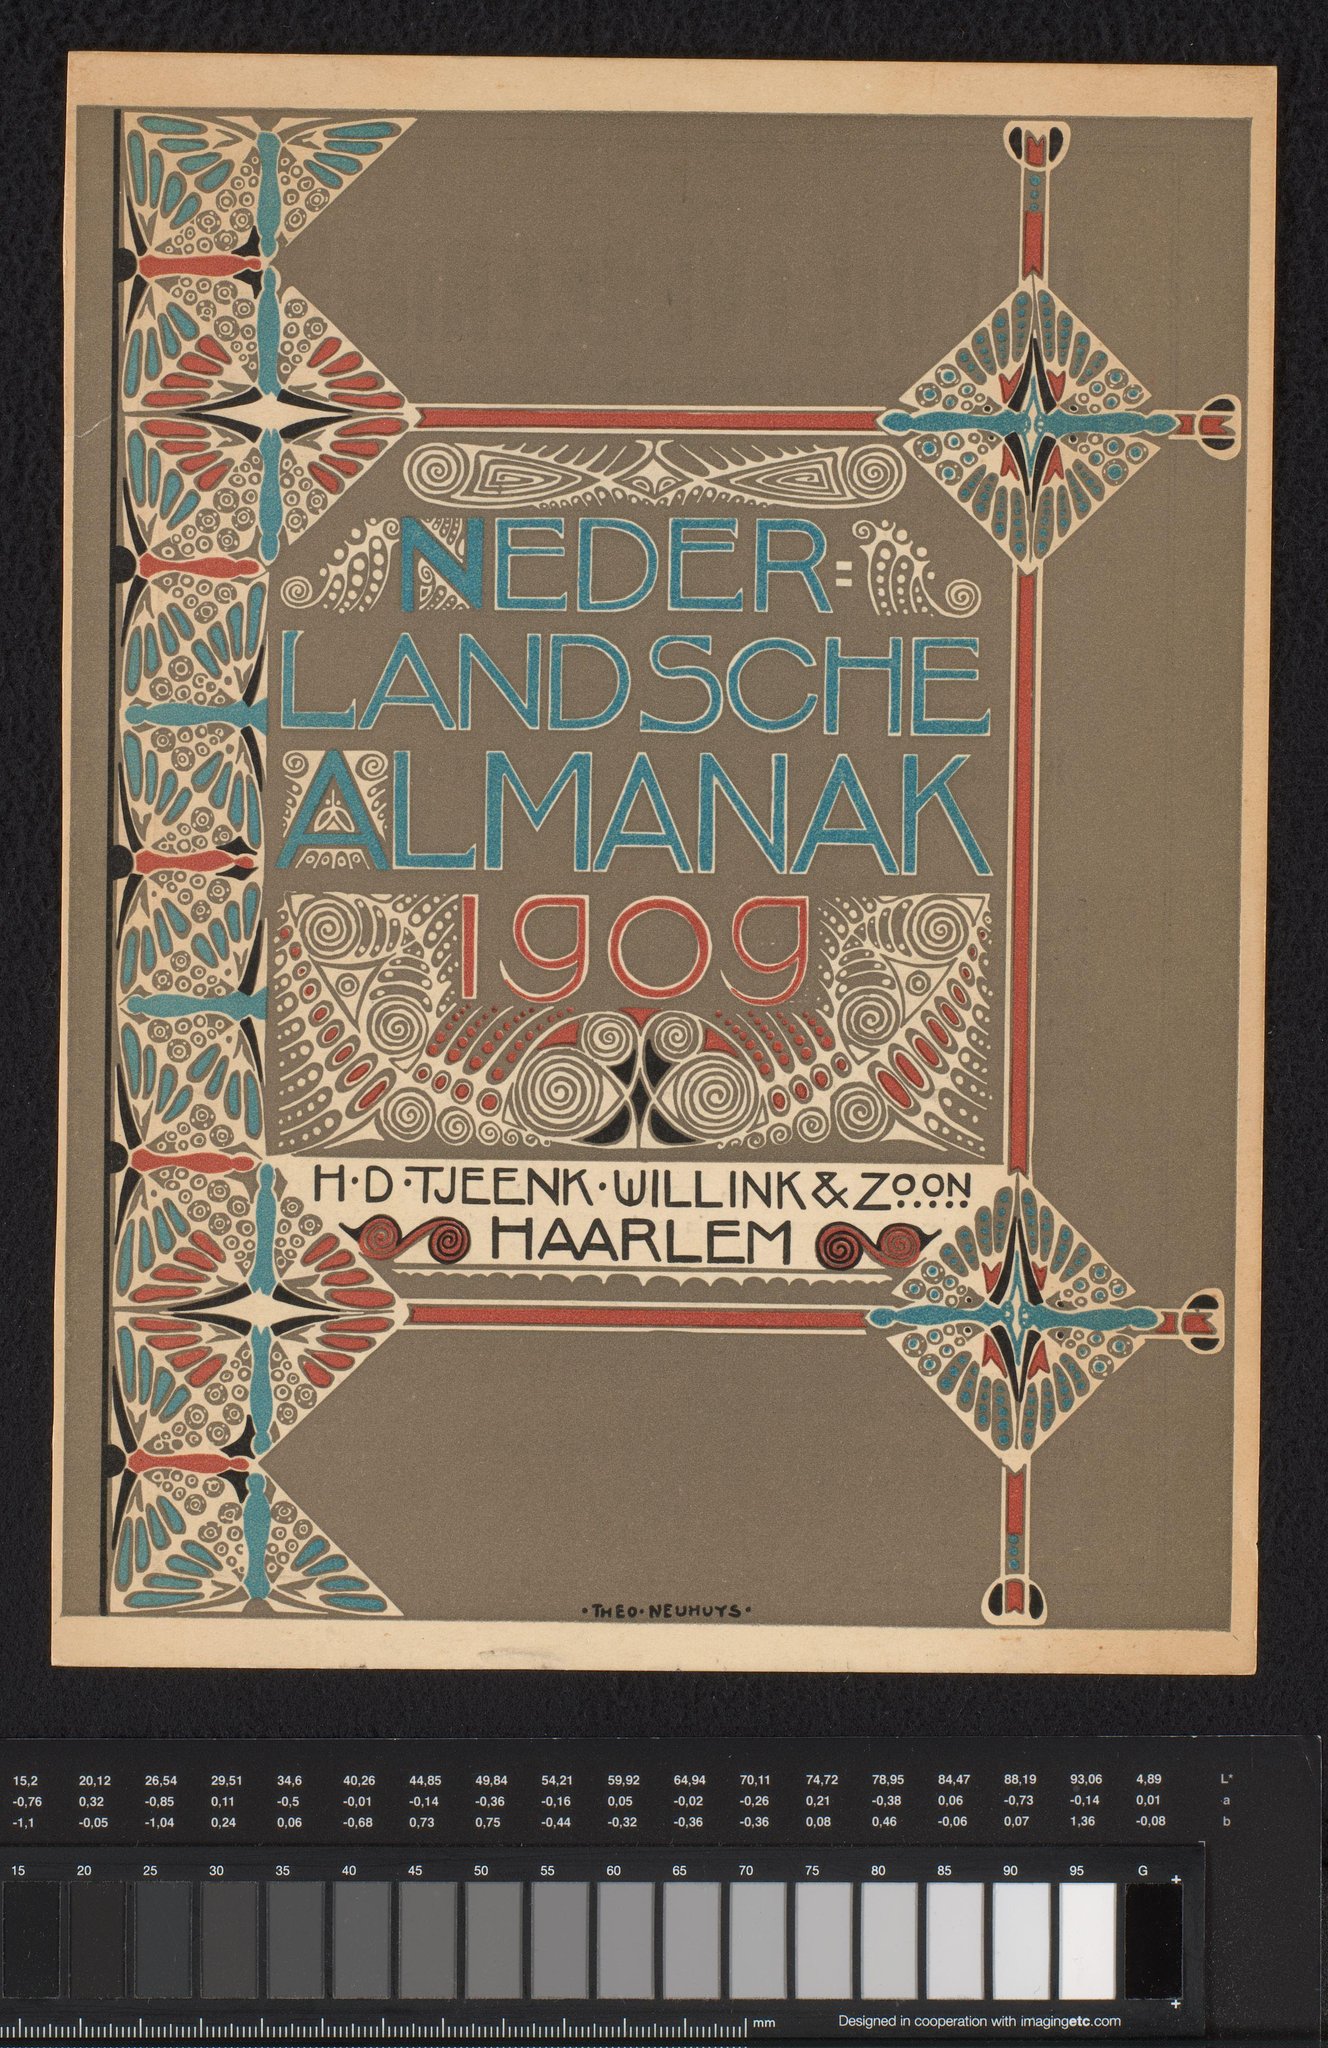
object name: wrapper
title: Omslag van 'Nederlandsche Almanak 1909'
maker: theo neuhuys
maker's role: draughtsman, print maker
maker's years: 1878-1921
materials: paper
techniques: lithograph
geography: london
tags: book-cover, binding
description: Omslag voor: Nederlandsche Almanak voor 1909. Haarlem: H.D. Tjeenk Willink & Zoon, 1909.